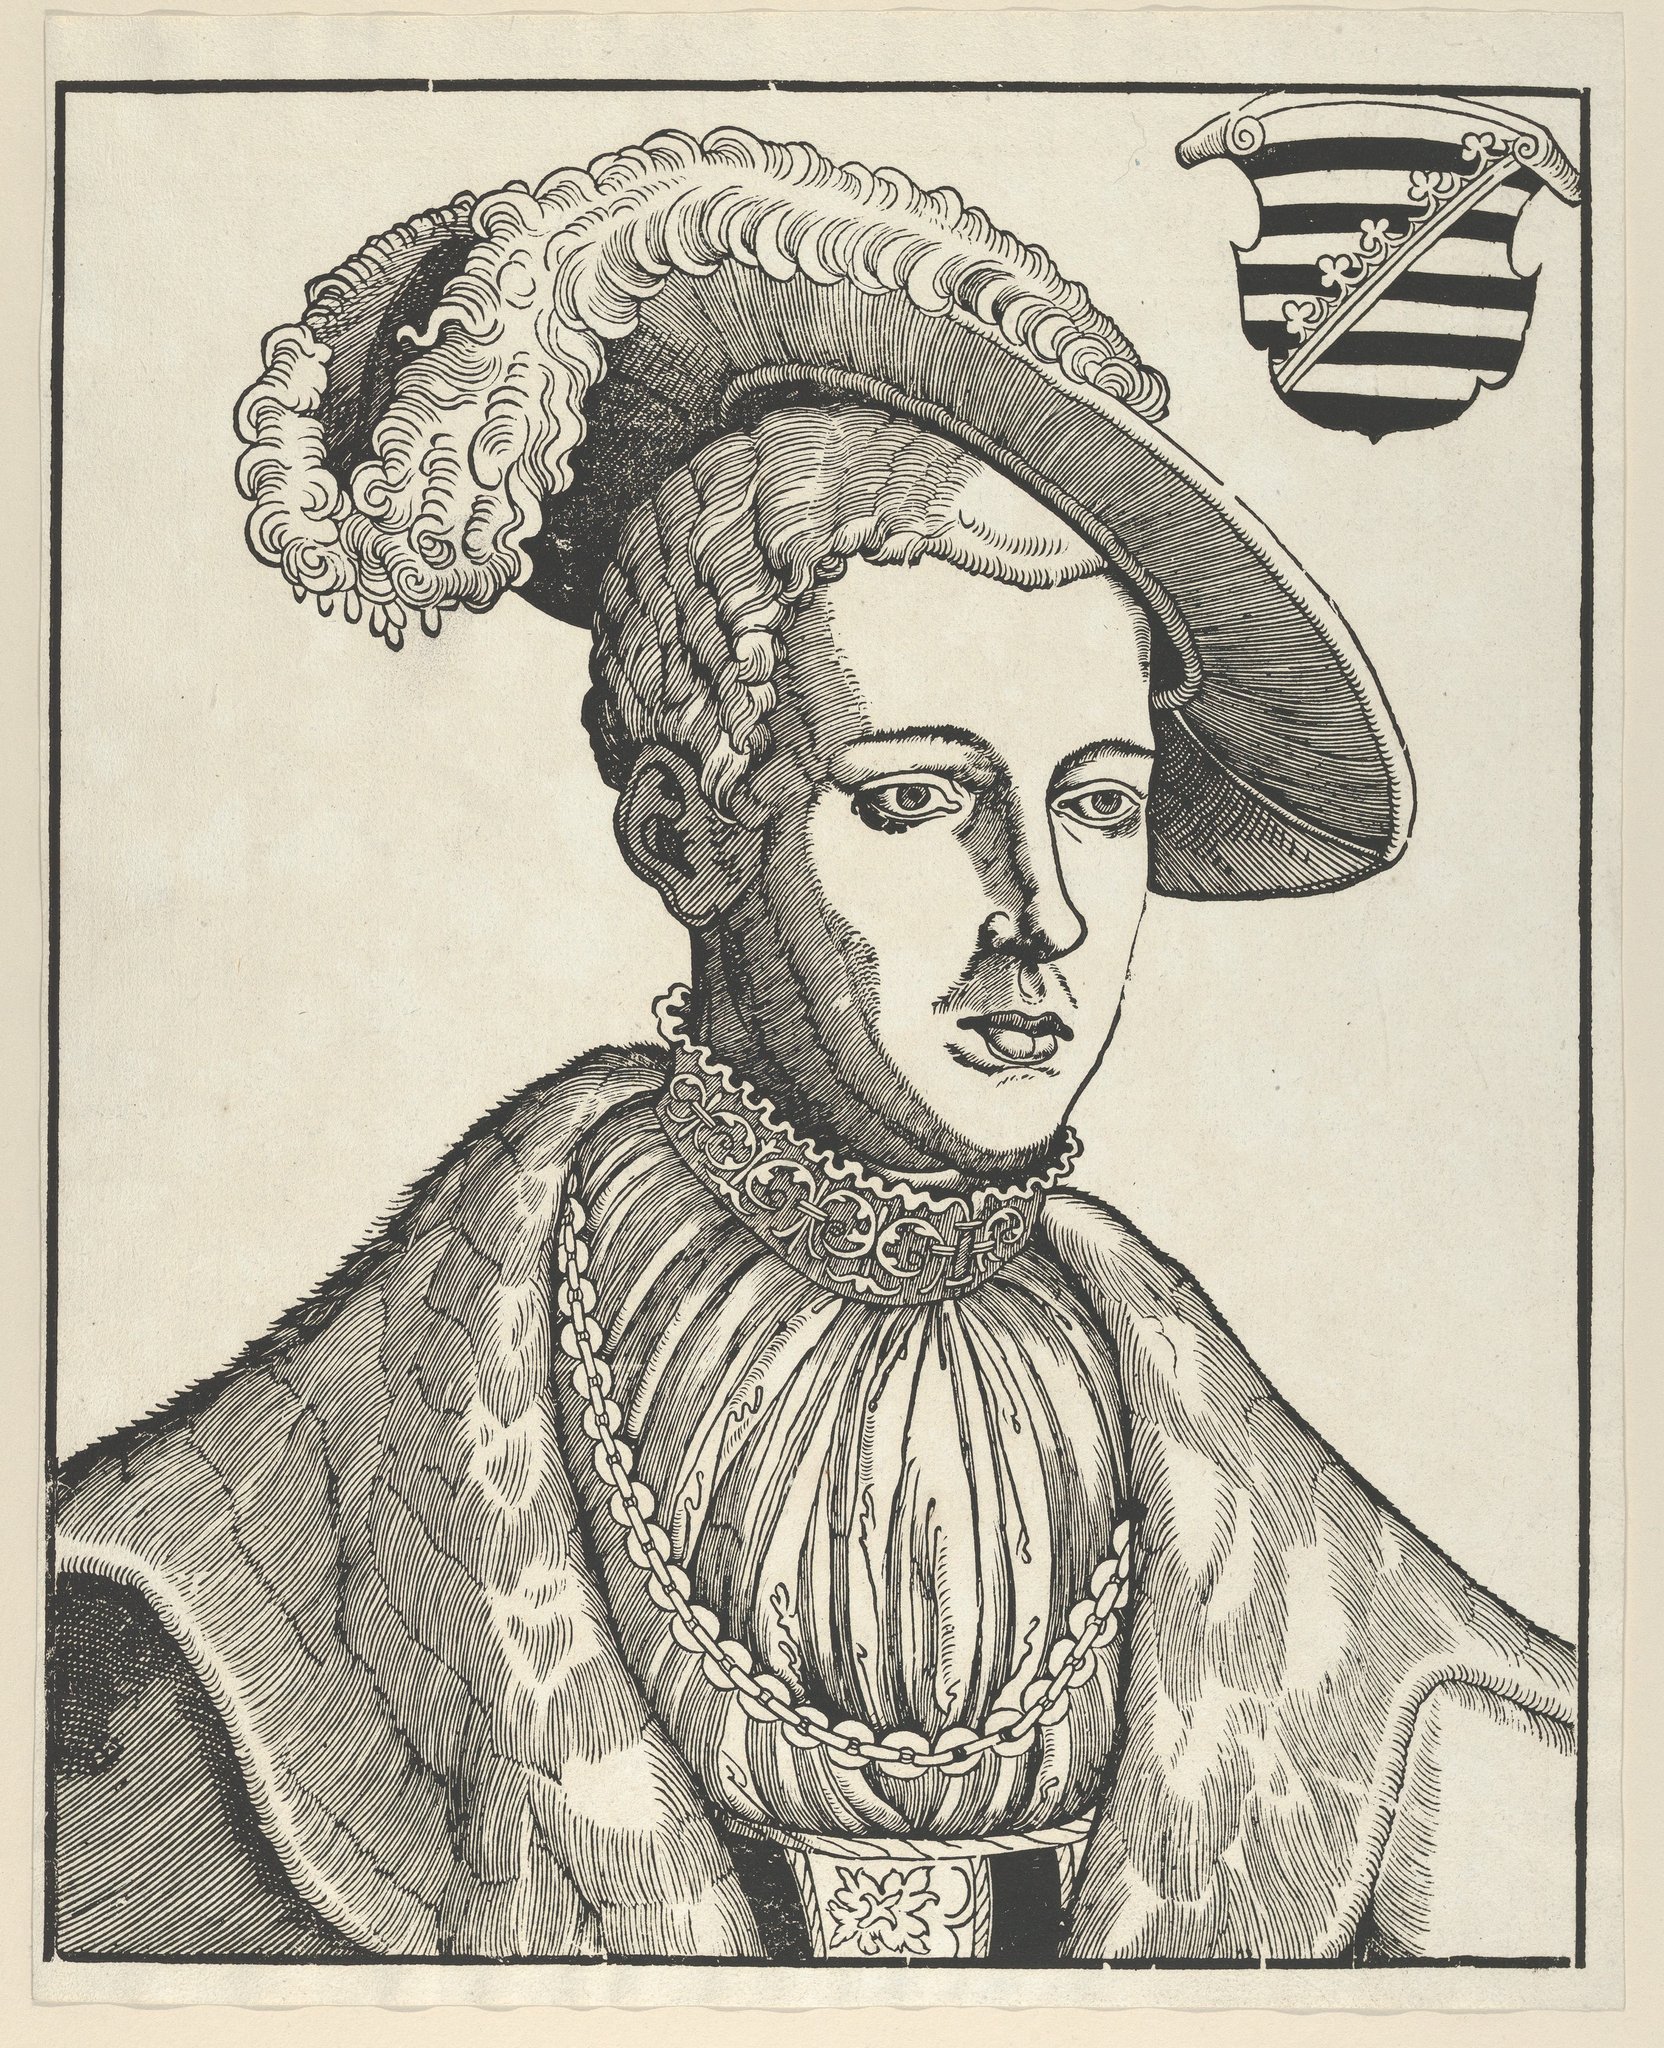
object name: print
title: Copy of Duke John Ernest of Saxony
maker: lucas cranach the elder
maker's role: artist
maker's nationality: german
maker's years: 1472-1553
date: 1472-1586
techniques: woodcut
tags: men,portraits,coat of arms